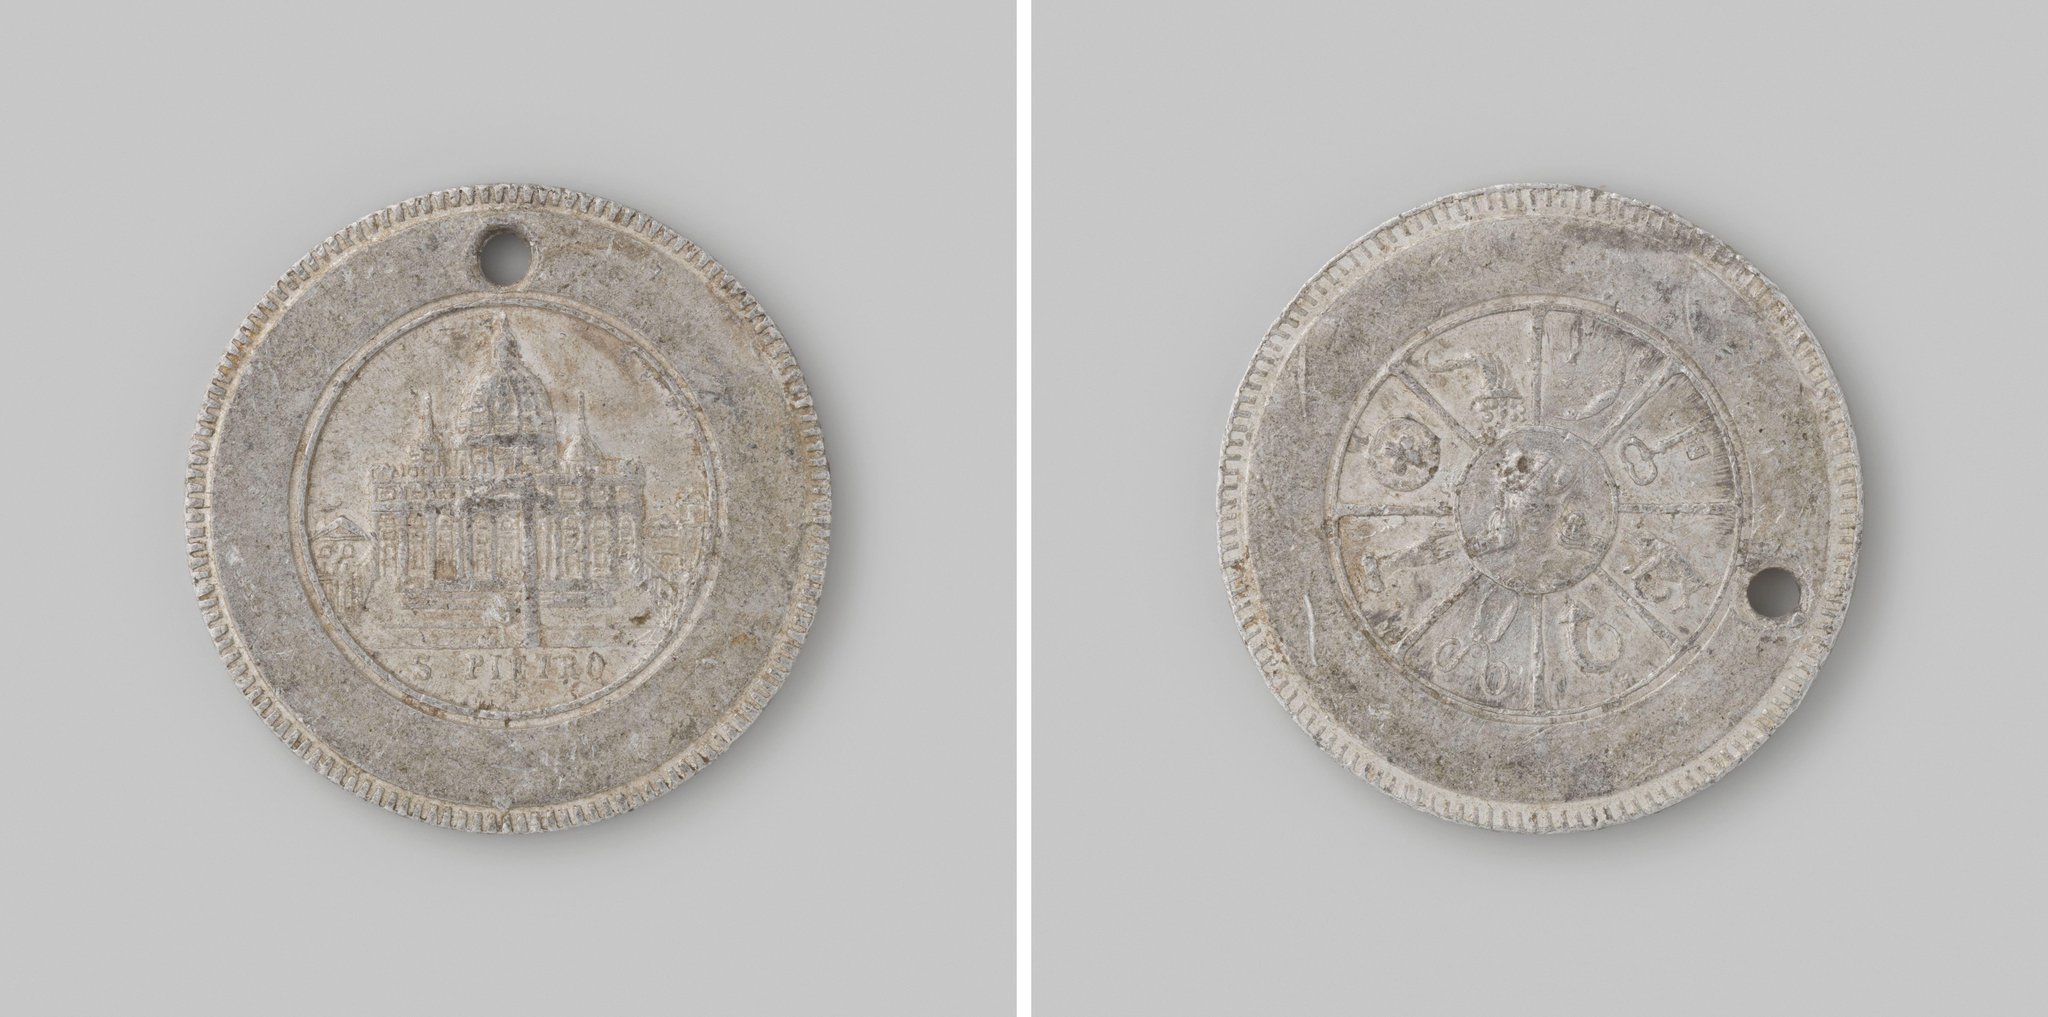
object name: history medal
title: Souvenir bezoek Sint Pieterskerk te Rome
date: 1900-1940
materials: aluminum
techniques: striking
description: Aluminium penning voor stempelautomaat, met doorboring, op de voorzijde de Sint-Pieterskerk met afsnedetekst waarbuiten een rand bestemd voor het instempelen van tekst, op de keerzijde een cirkel verdeeld in acht vakken met afbeeldingen en centraal een vak met een meisjesportret.